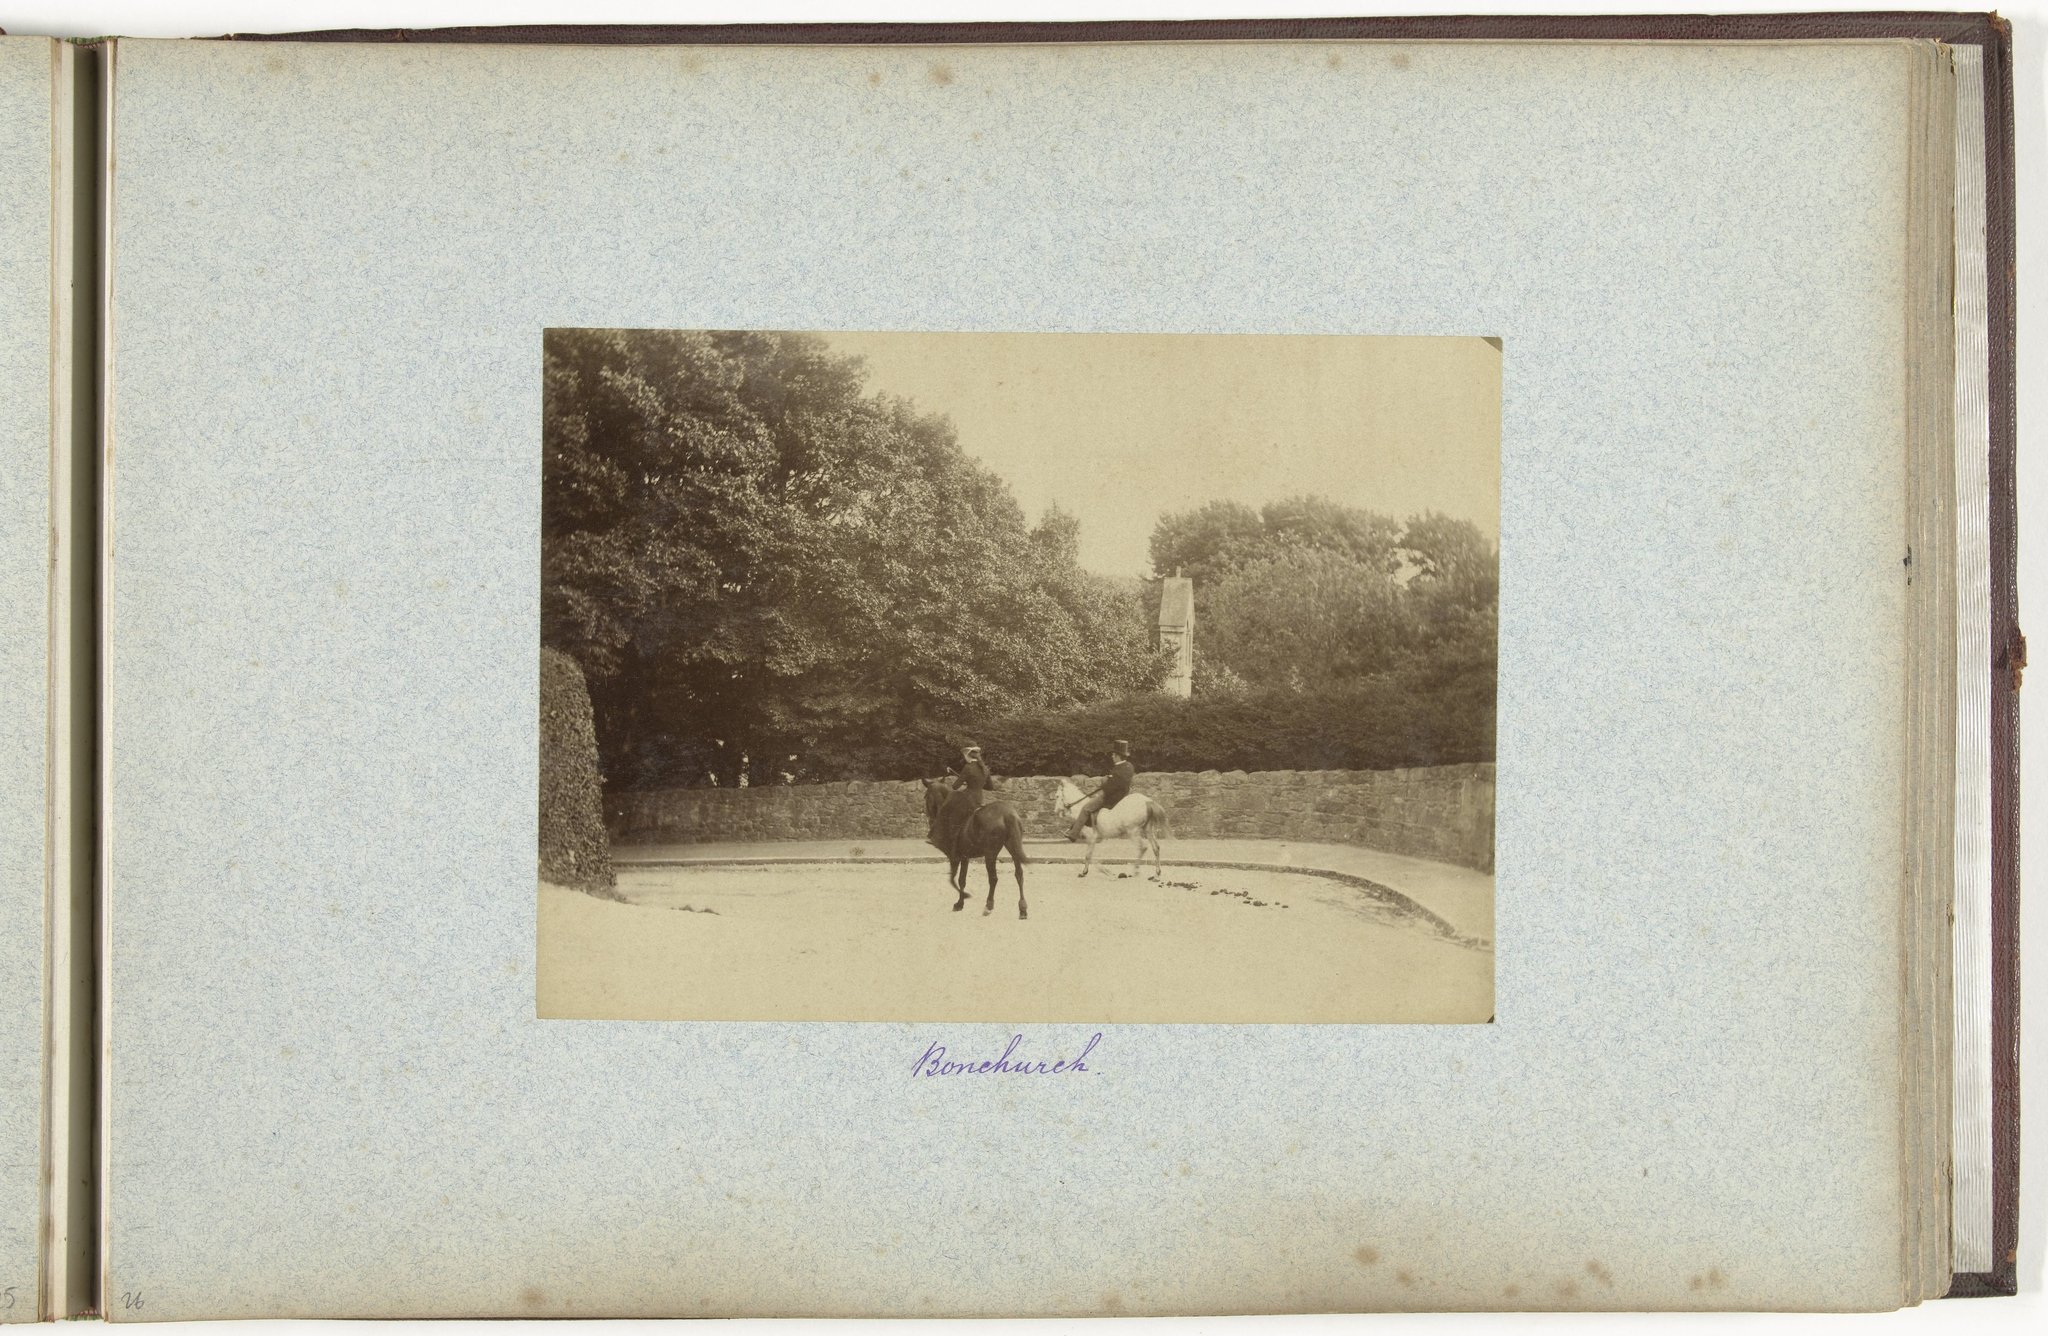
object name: album leaf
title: Bonchurch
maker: henry pauw van wieldrecht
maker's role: fotograaf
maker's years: 1863-1912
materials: cardboard, paper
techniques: albumen print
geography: bonchurch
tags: riding a horse, ass, or mule; rider, horseman, street